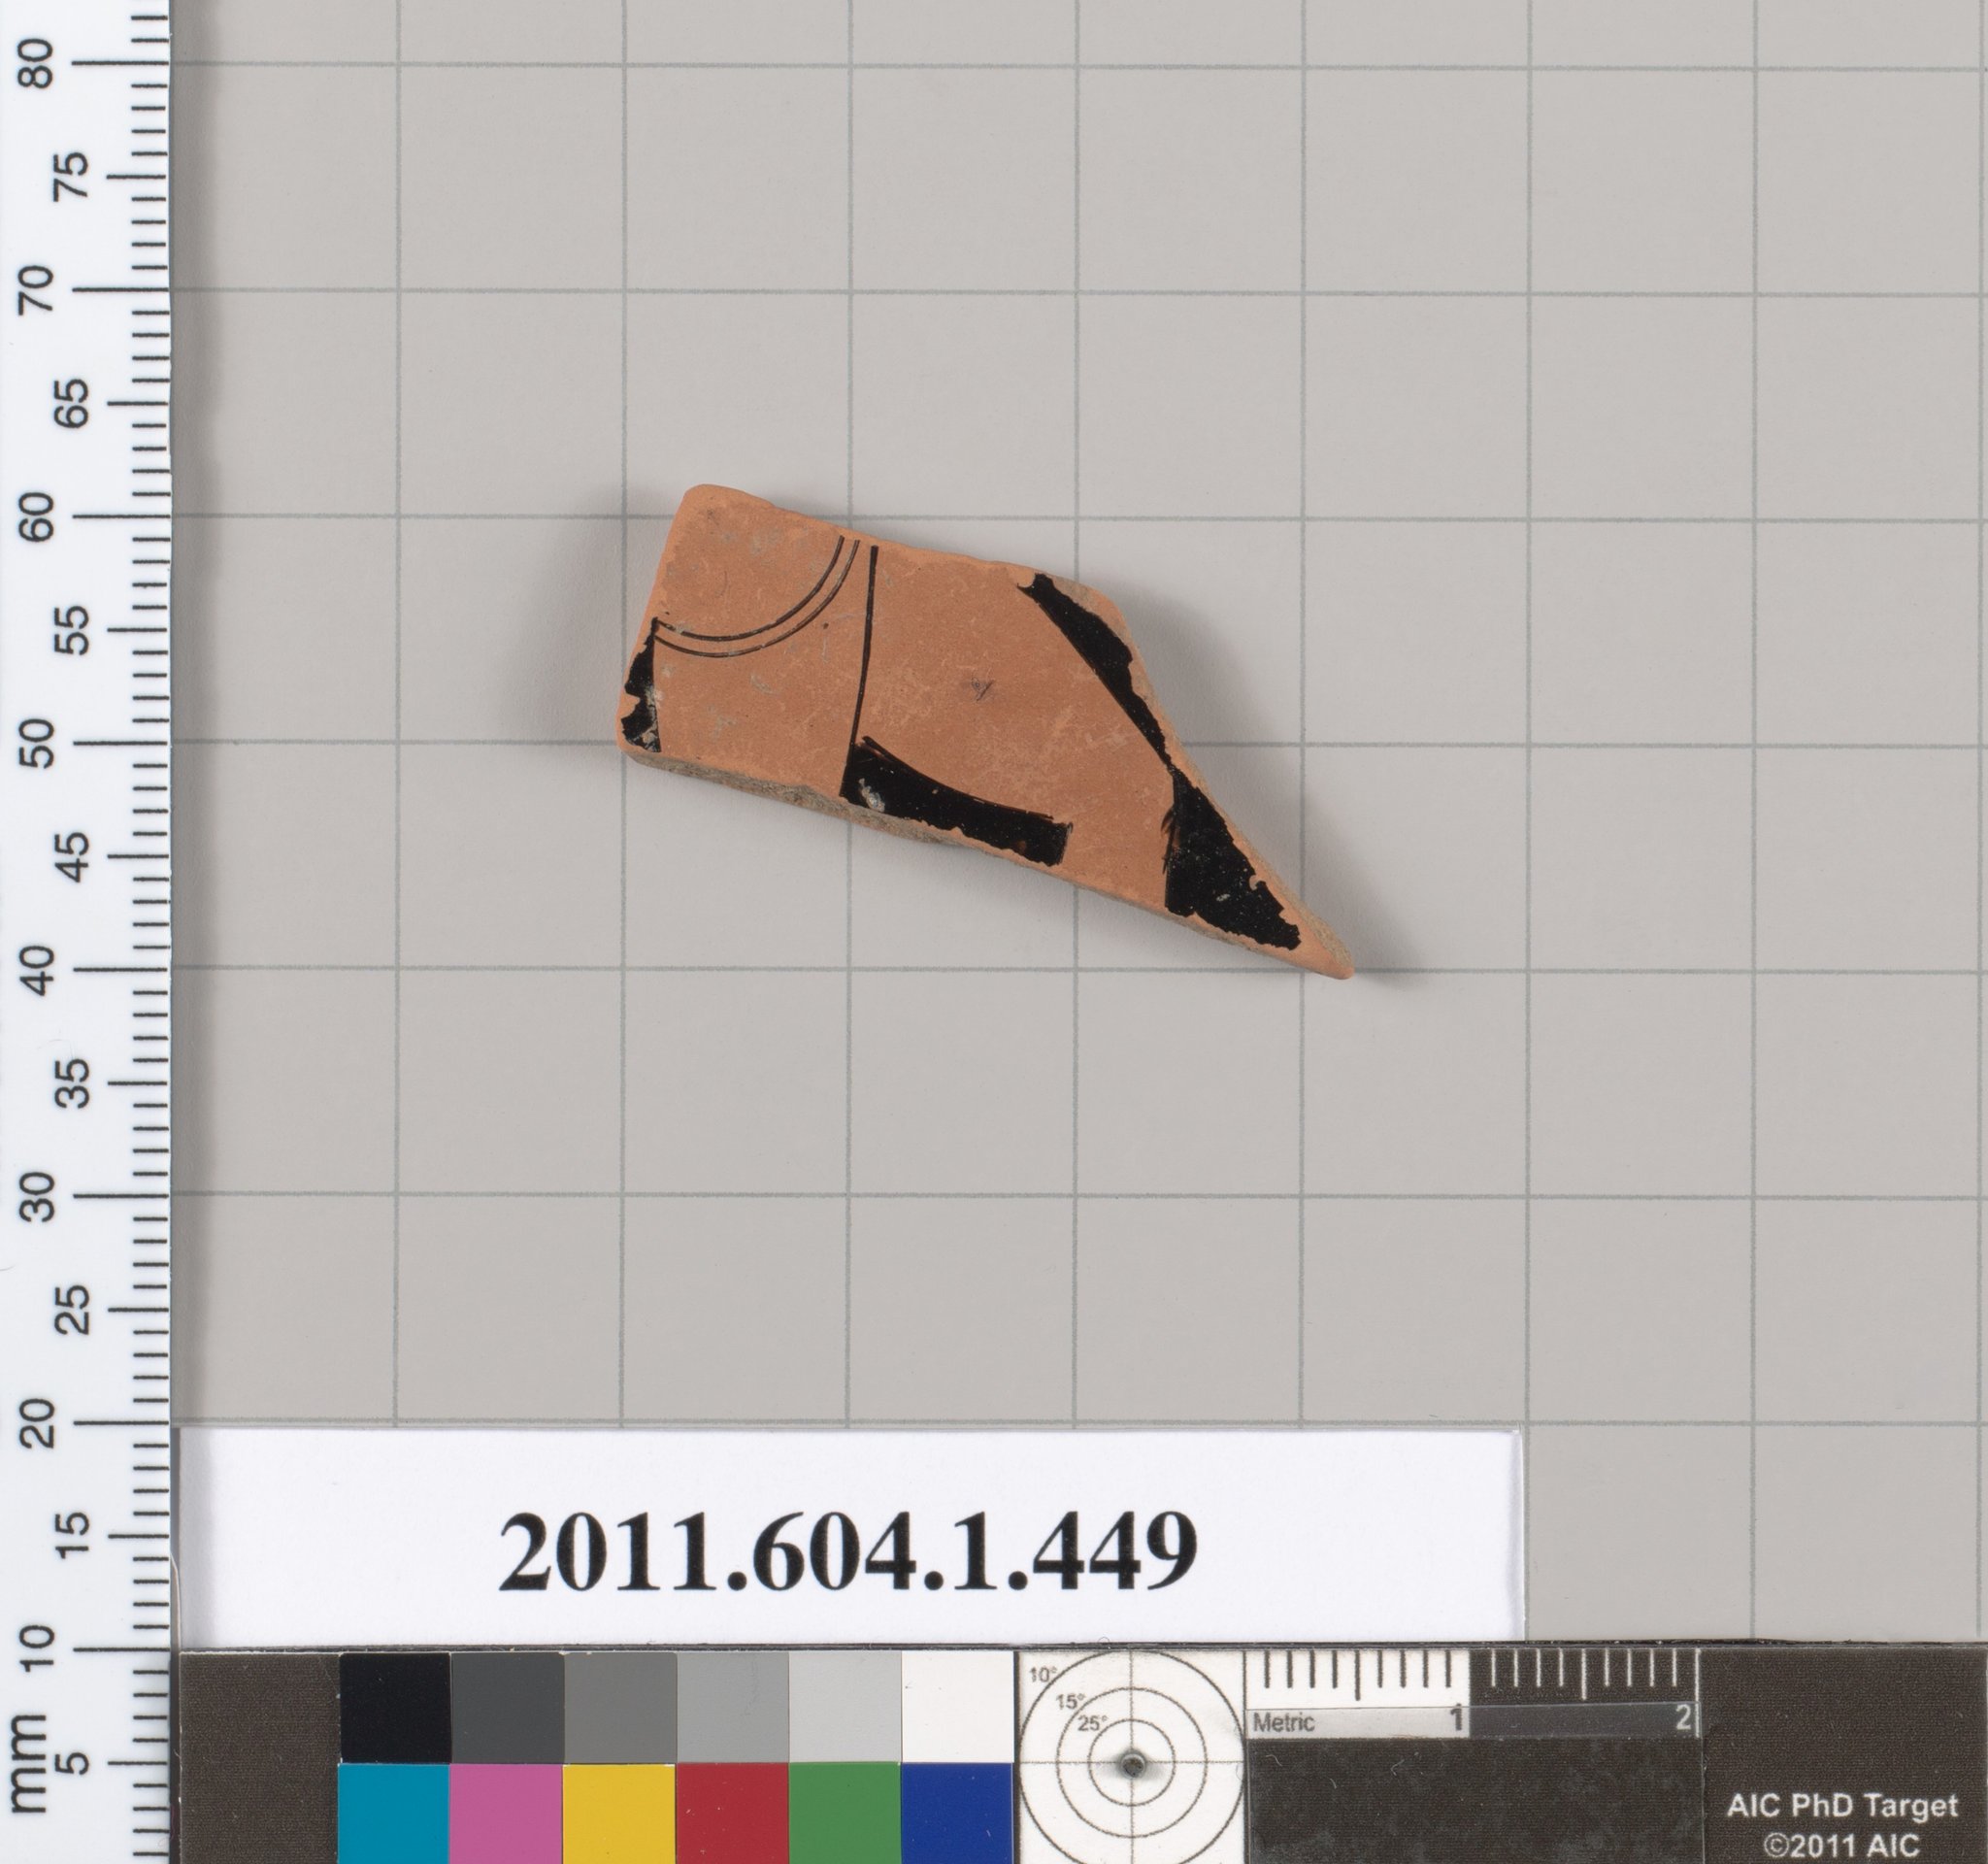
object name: kylix fragment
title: Terracotta fragment of a kylix (drinking cup)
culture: greek, attic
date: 475-451 BCE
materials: terracotta